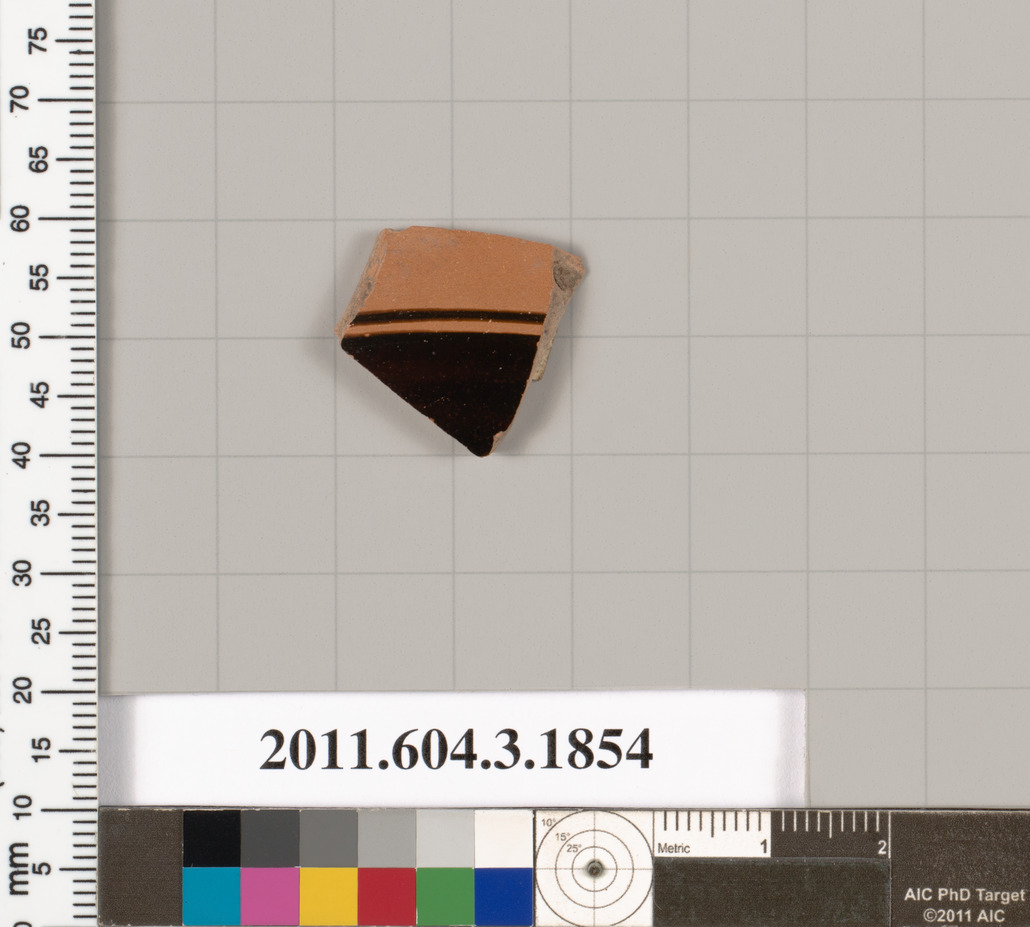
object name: kylix fragment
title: Terracotta fragment of a kylix: Lip cup (drinking cup)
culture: greek, attic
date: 560-525 BCE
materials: terracotta